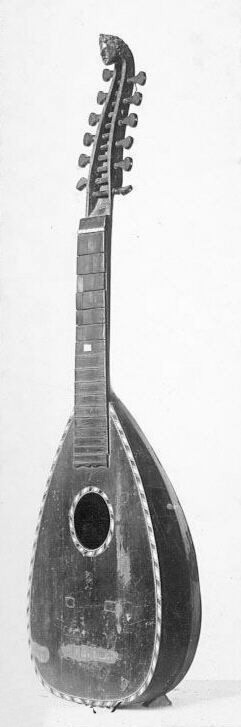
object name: mandora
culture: french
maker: hénocq (the younger)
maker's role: maker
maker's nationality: french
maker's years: 1775-1789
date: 1778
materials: wood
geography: france